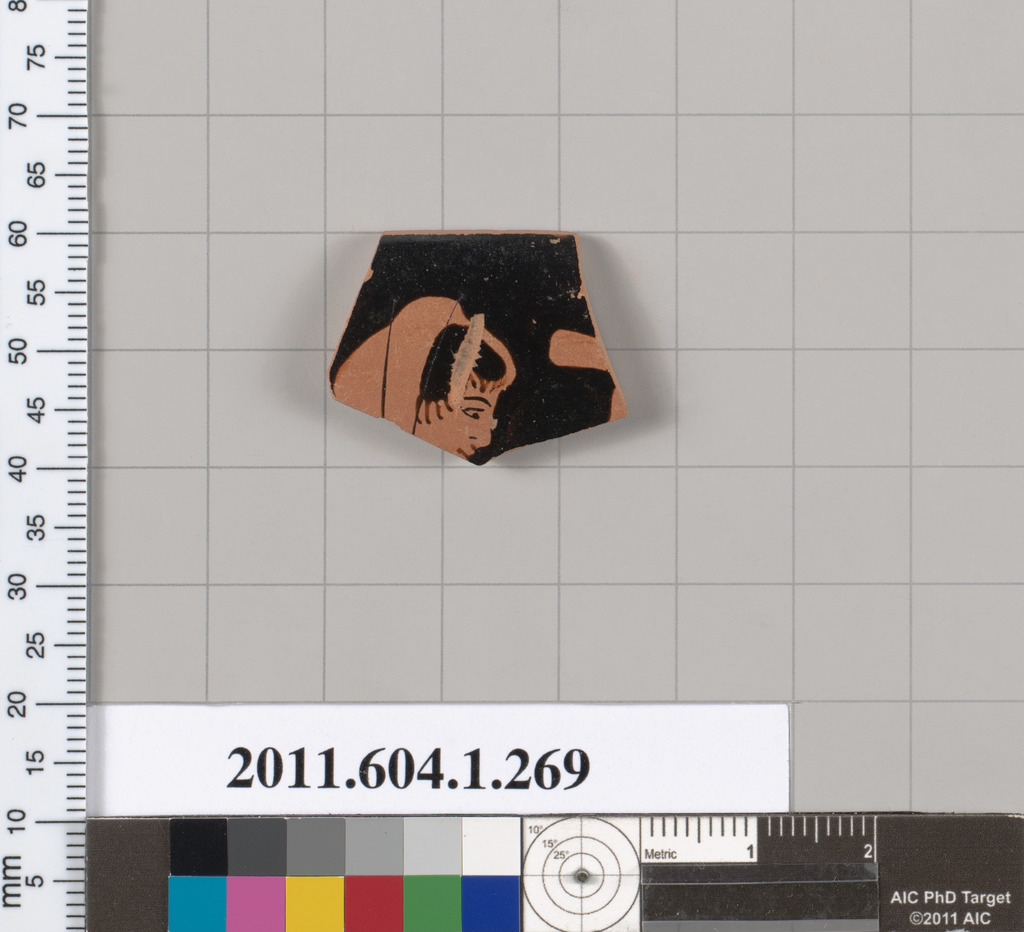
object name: kylix fragment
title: Terracotta rim fragment of a kylix (drinking cup)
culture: greek, attic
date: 475-451 BCE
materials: terracotta